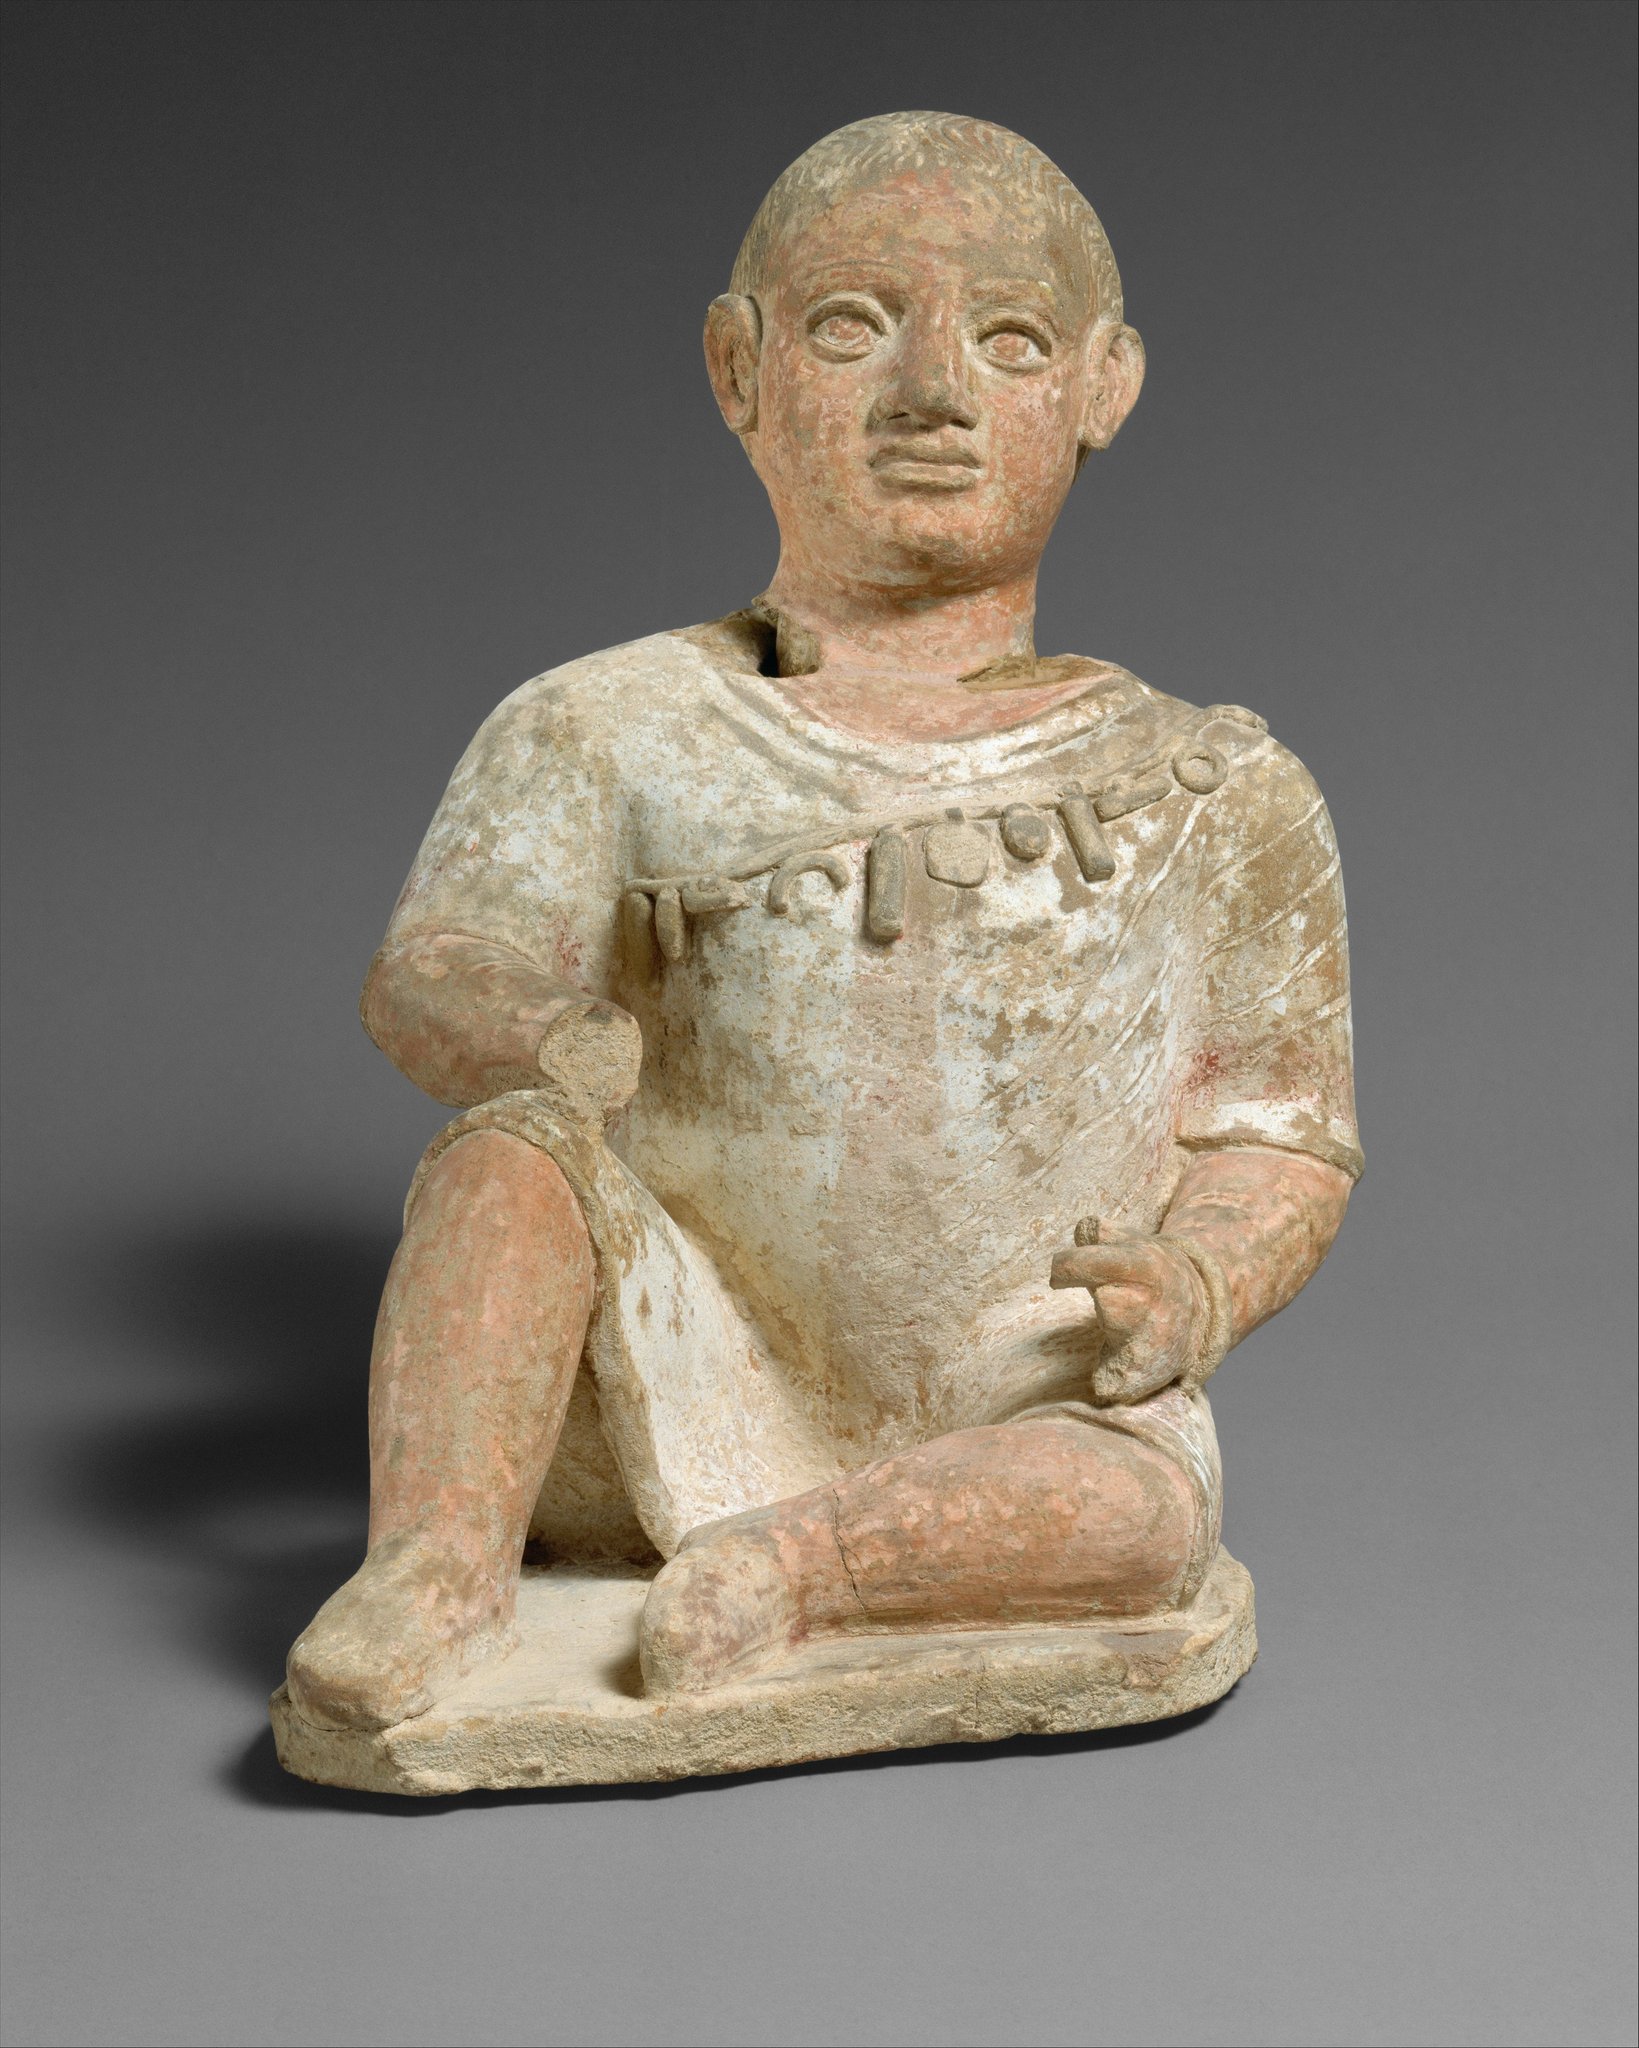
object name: statuette of a temple boy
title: Seated boy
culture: cypriot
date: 325-300 BCE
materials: terracotta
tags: boys